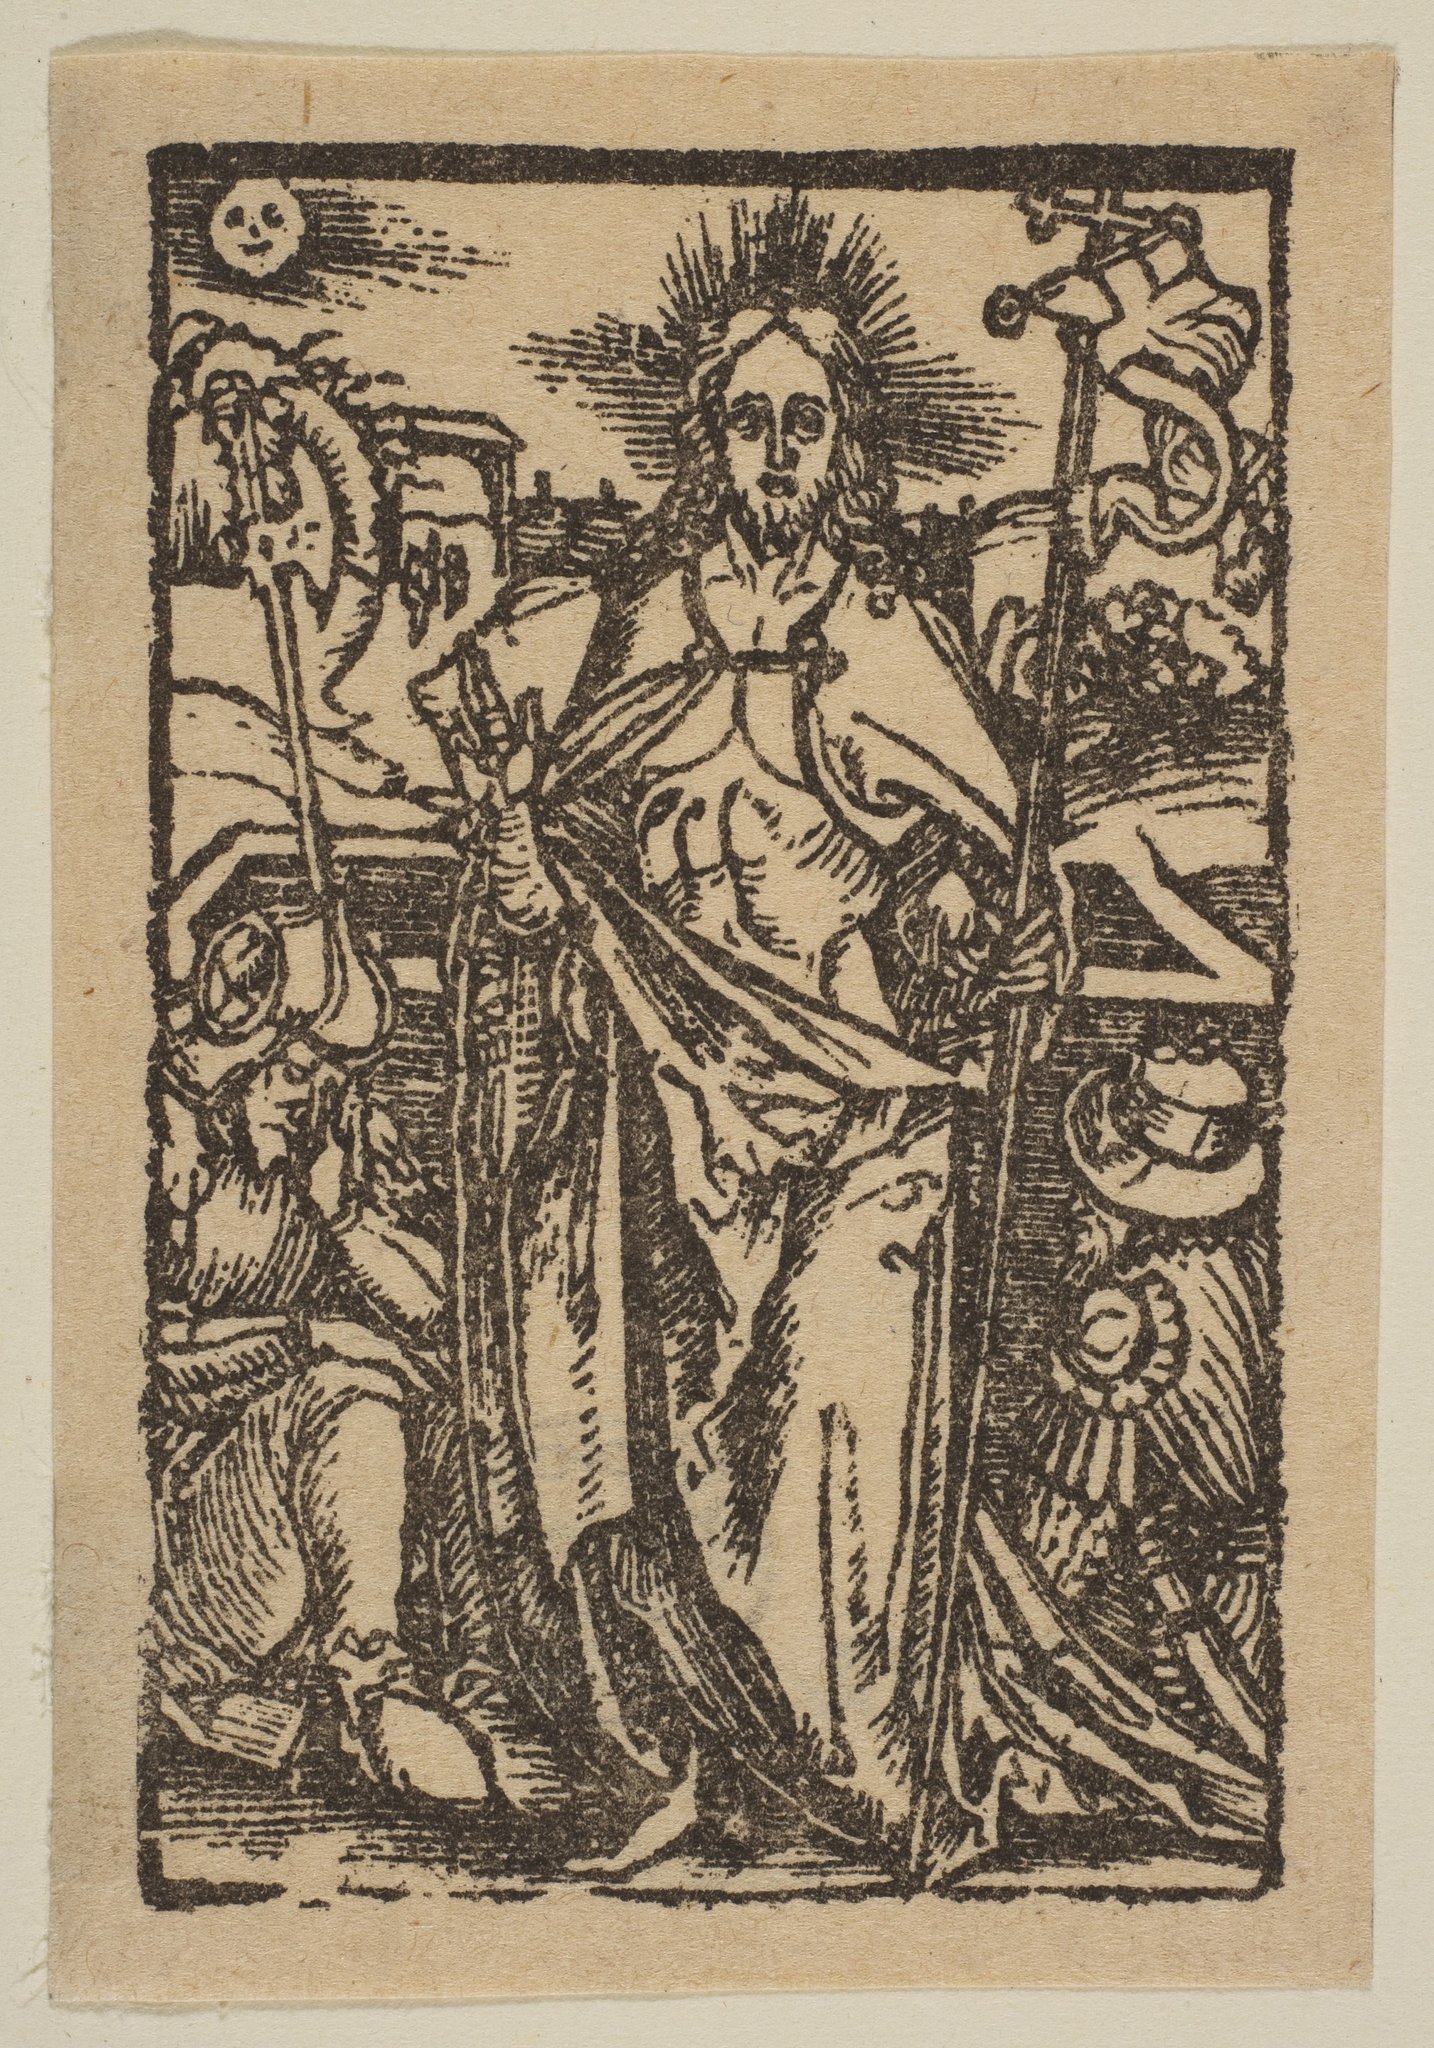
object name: print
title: The Resurrection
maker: albrecht dürer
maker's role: artist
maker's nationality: german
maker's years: 1471-1528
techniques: woodcut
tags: christ,resurrection